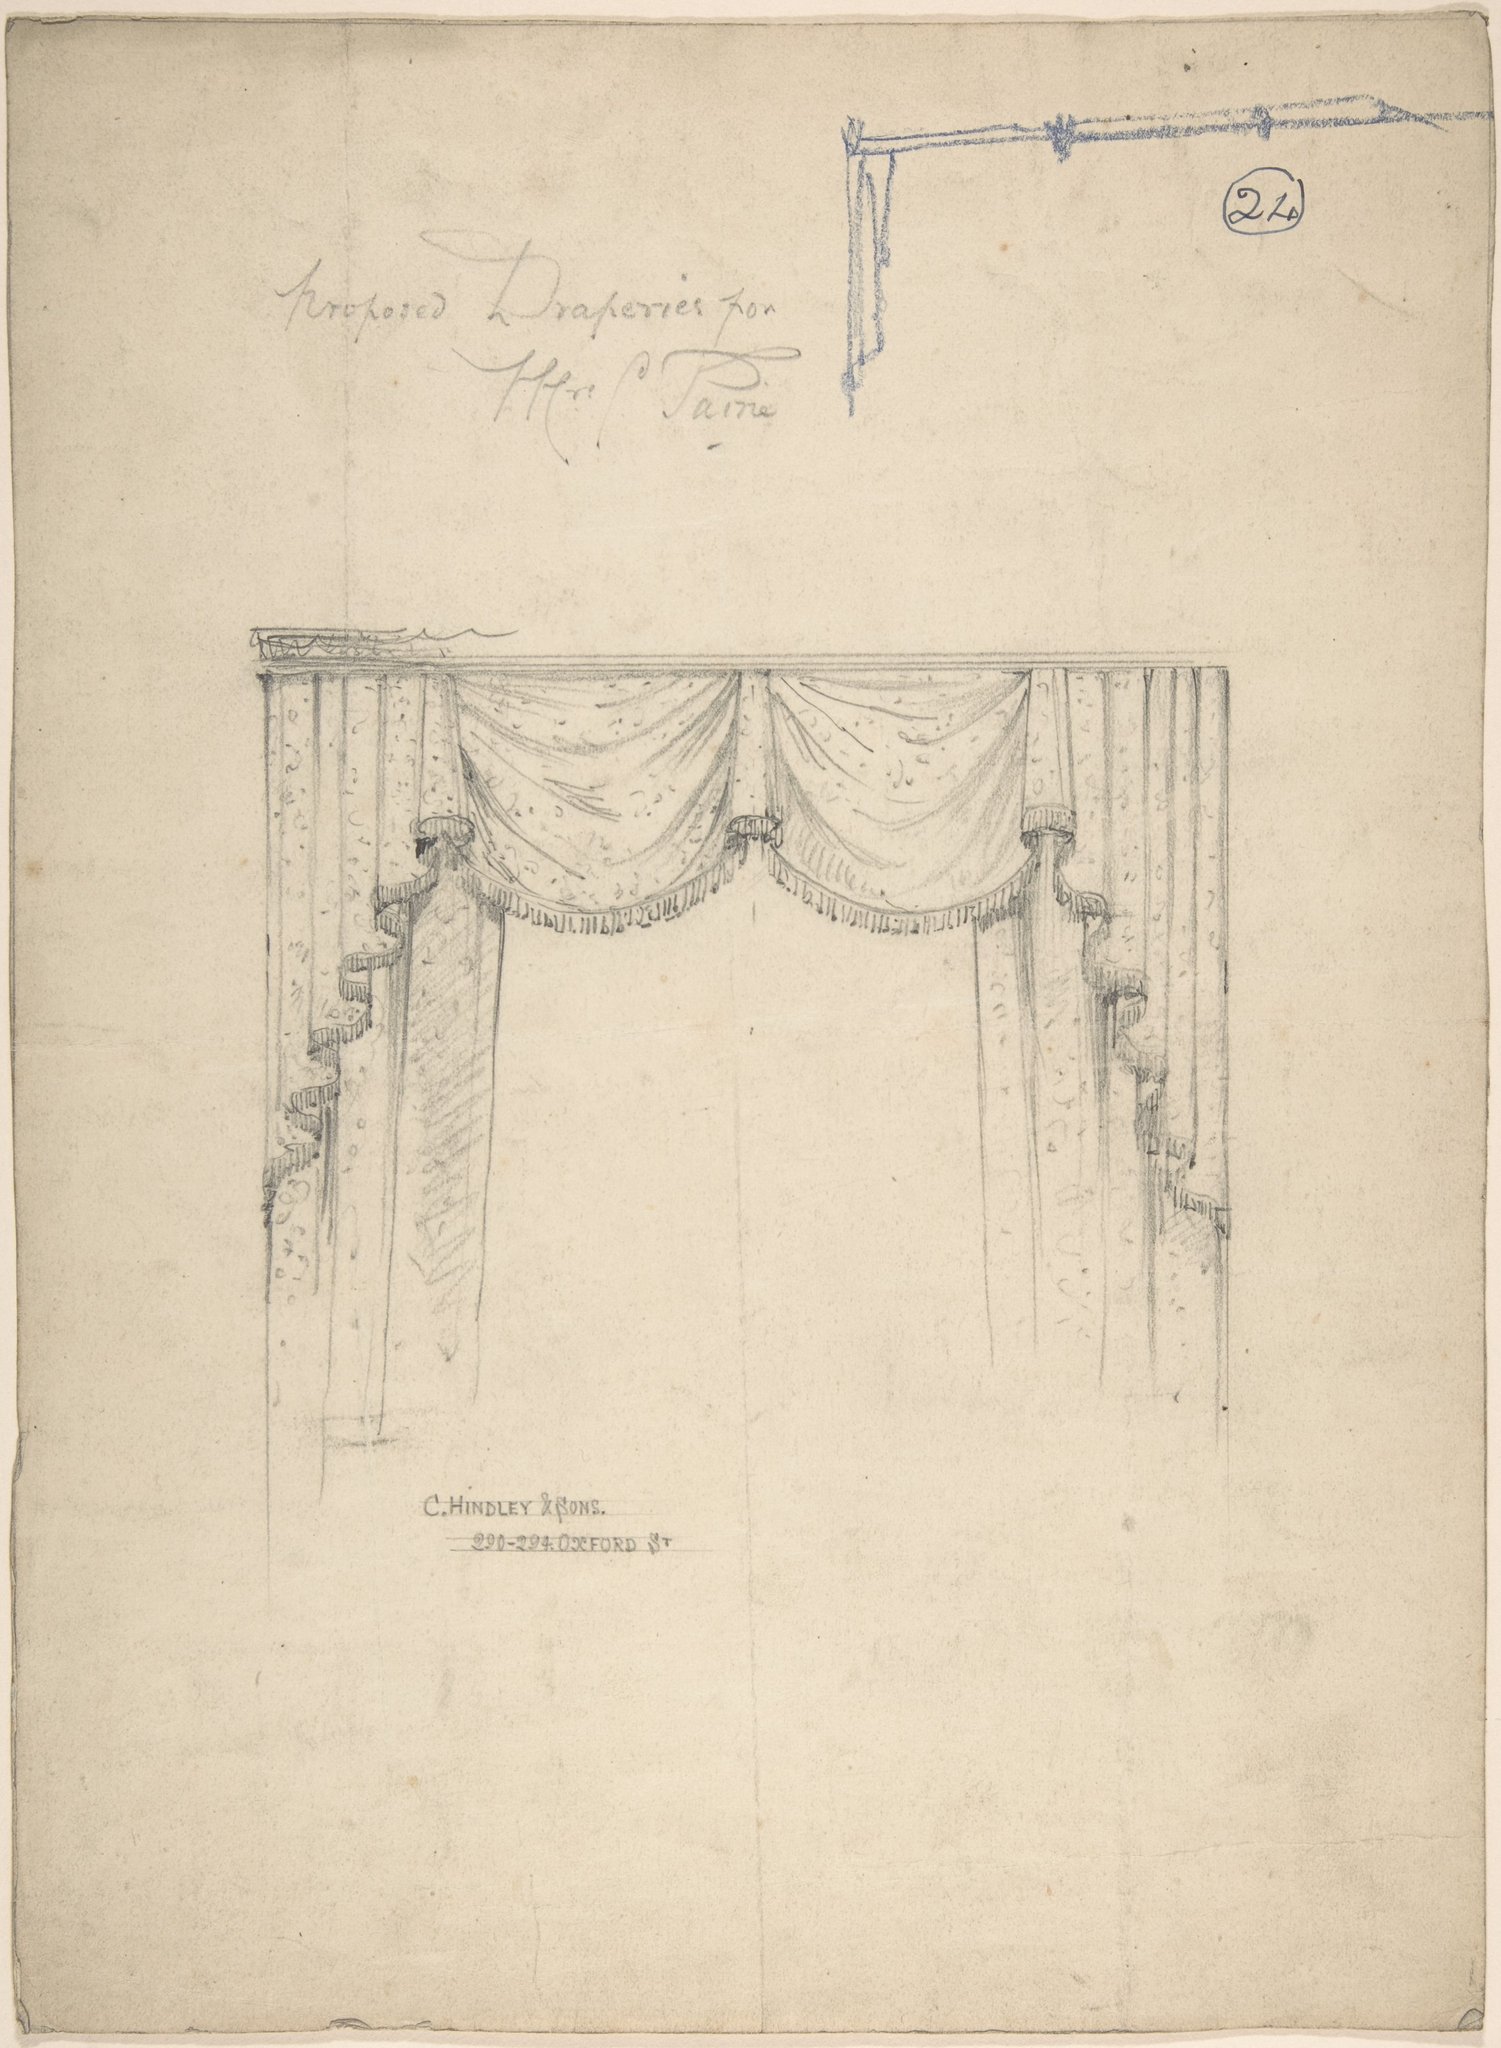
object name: drawing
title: Design for Curtains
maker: charles hindley and sons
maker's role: artist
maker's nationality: british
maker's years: 1841-1917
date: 1841-1884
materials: graphite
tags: curtains